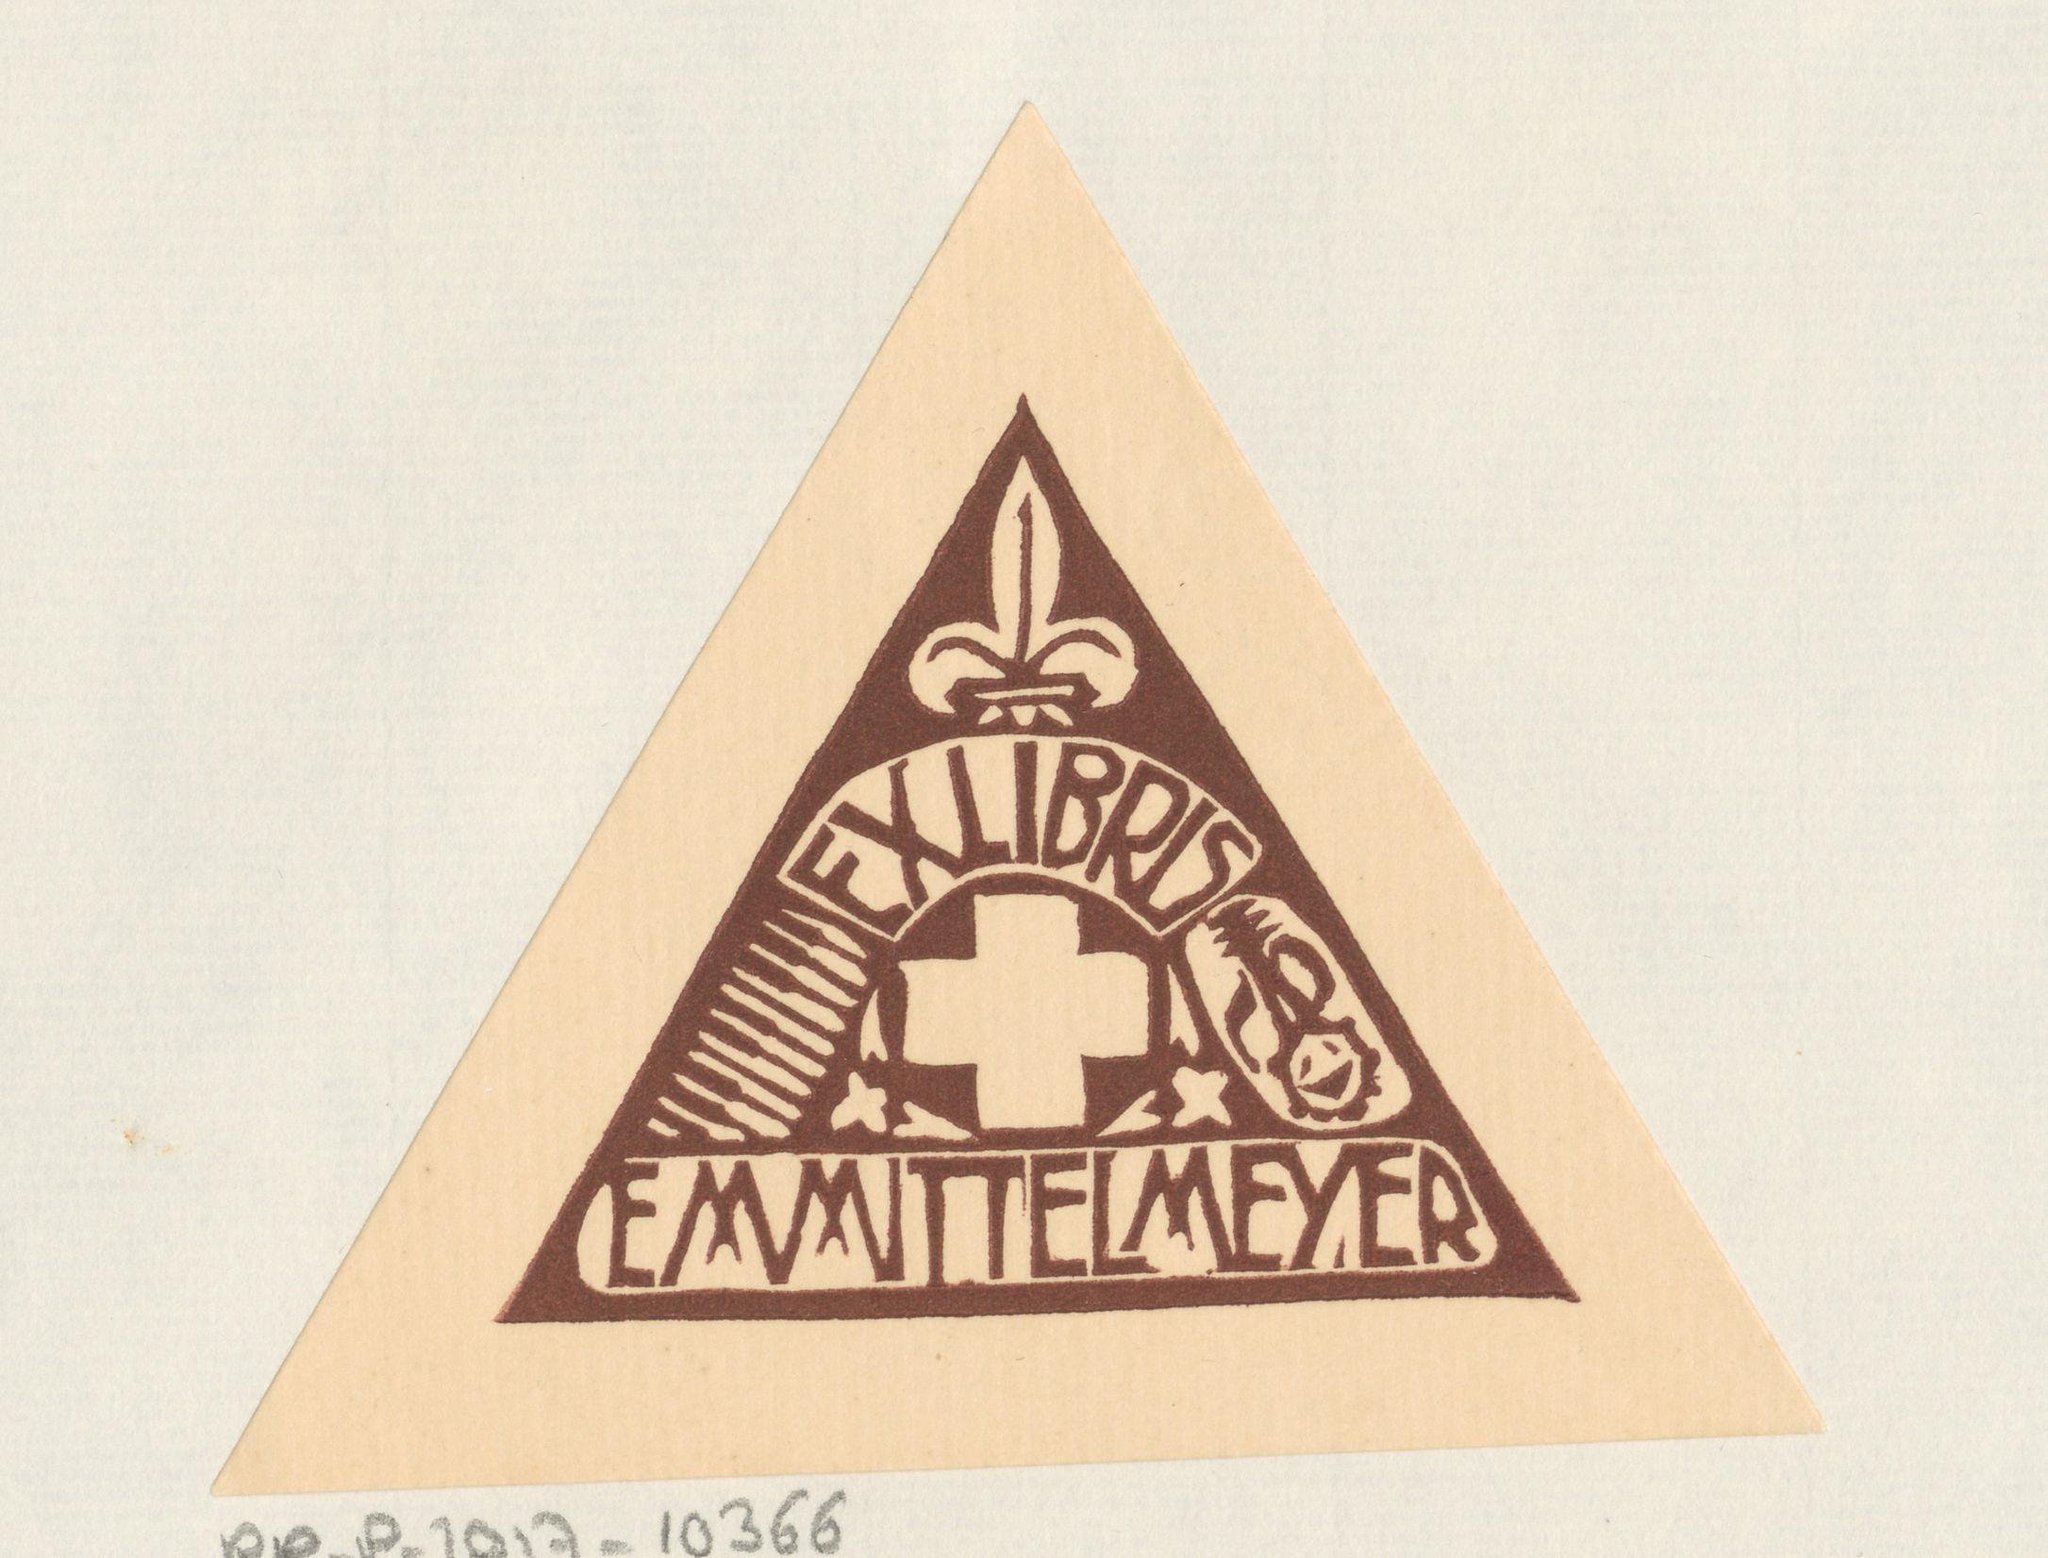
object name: bookplate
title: Ex libris van E.M. Mittelmeyer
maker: Anonymous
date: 1930-1999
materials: paper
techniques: linocut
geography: germany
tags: fleur-de-lis ~ ornament, keyboard instruments